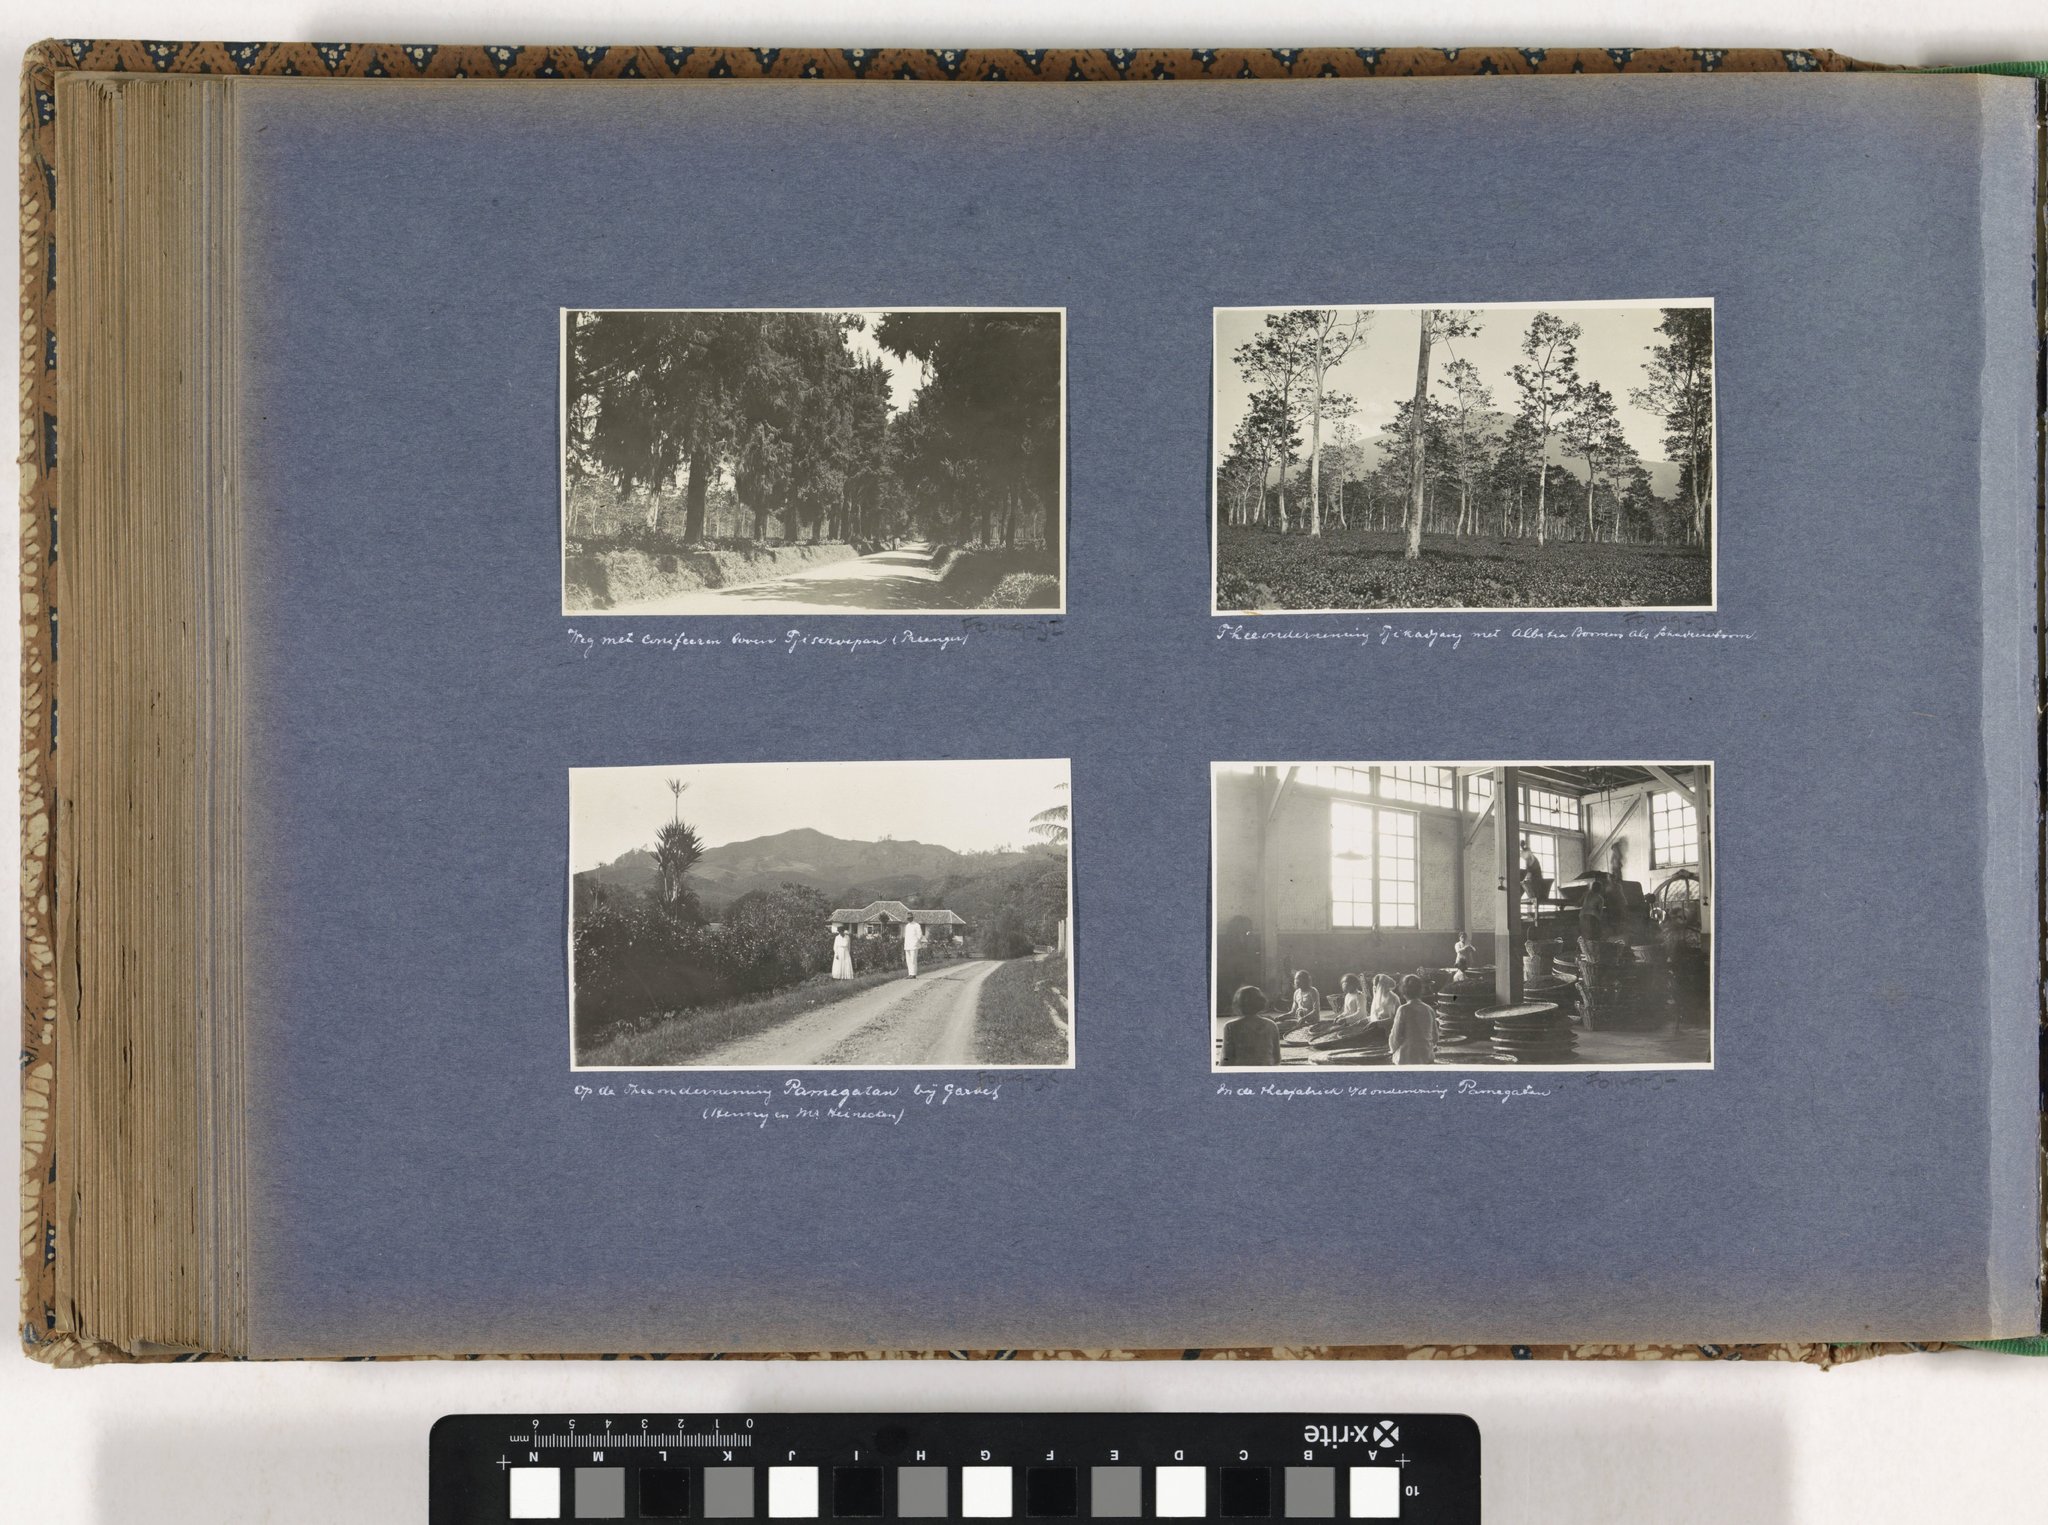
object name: photograph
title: Velden met schaduwbomen van thee-onderneming Tjikadjang bij Garvet in Preanger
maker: Anonymous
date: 1900-1920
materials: paper, photographic support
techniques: gelatin silver print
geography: preanger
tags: plantation, field filled with a crop, trees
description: Onderdeel van reisalbum met foto's van bedrijvigheid en bezienswaardigheden op Sumatra en Java en van de reis naar en van Nederlands-Indië.